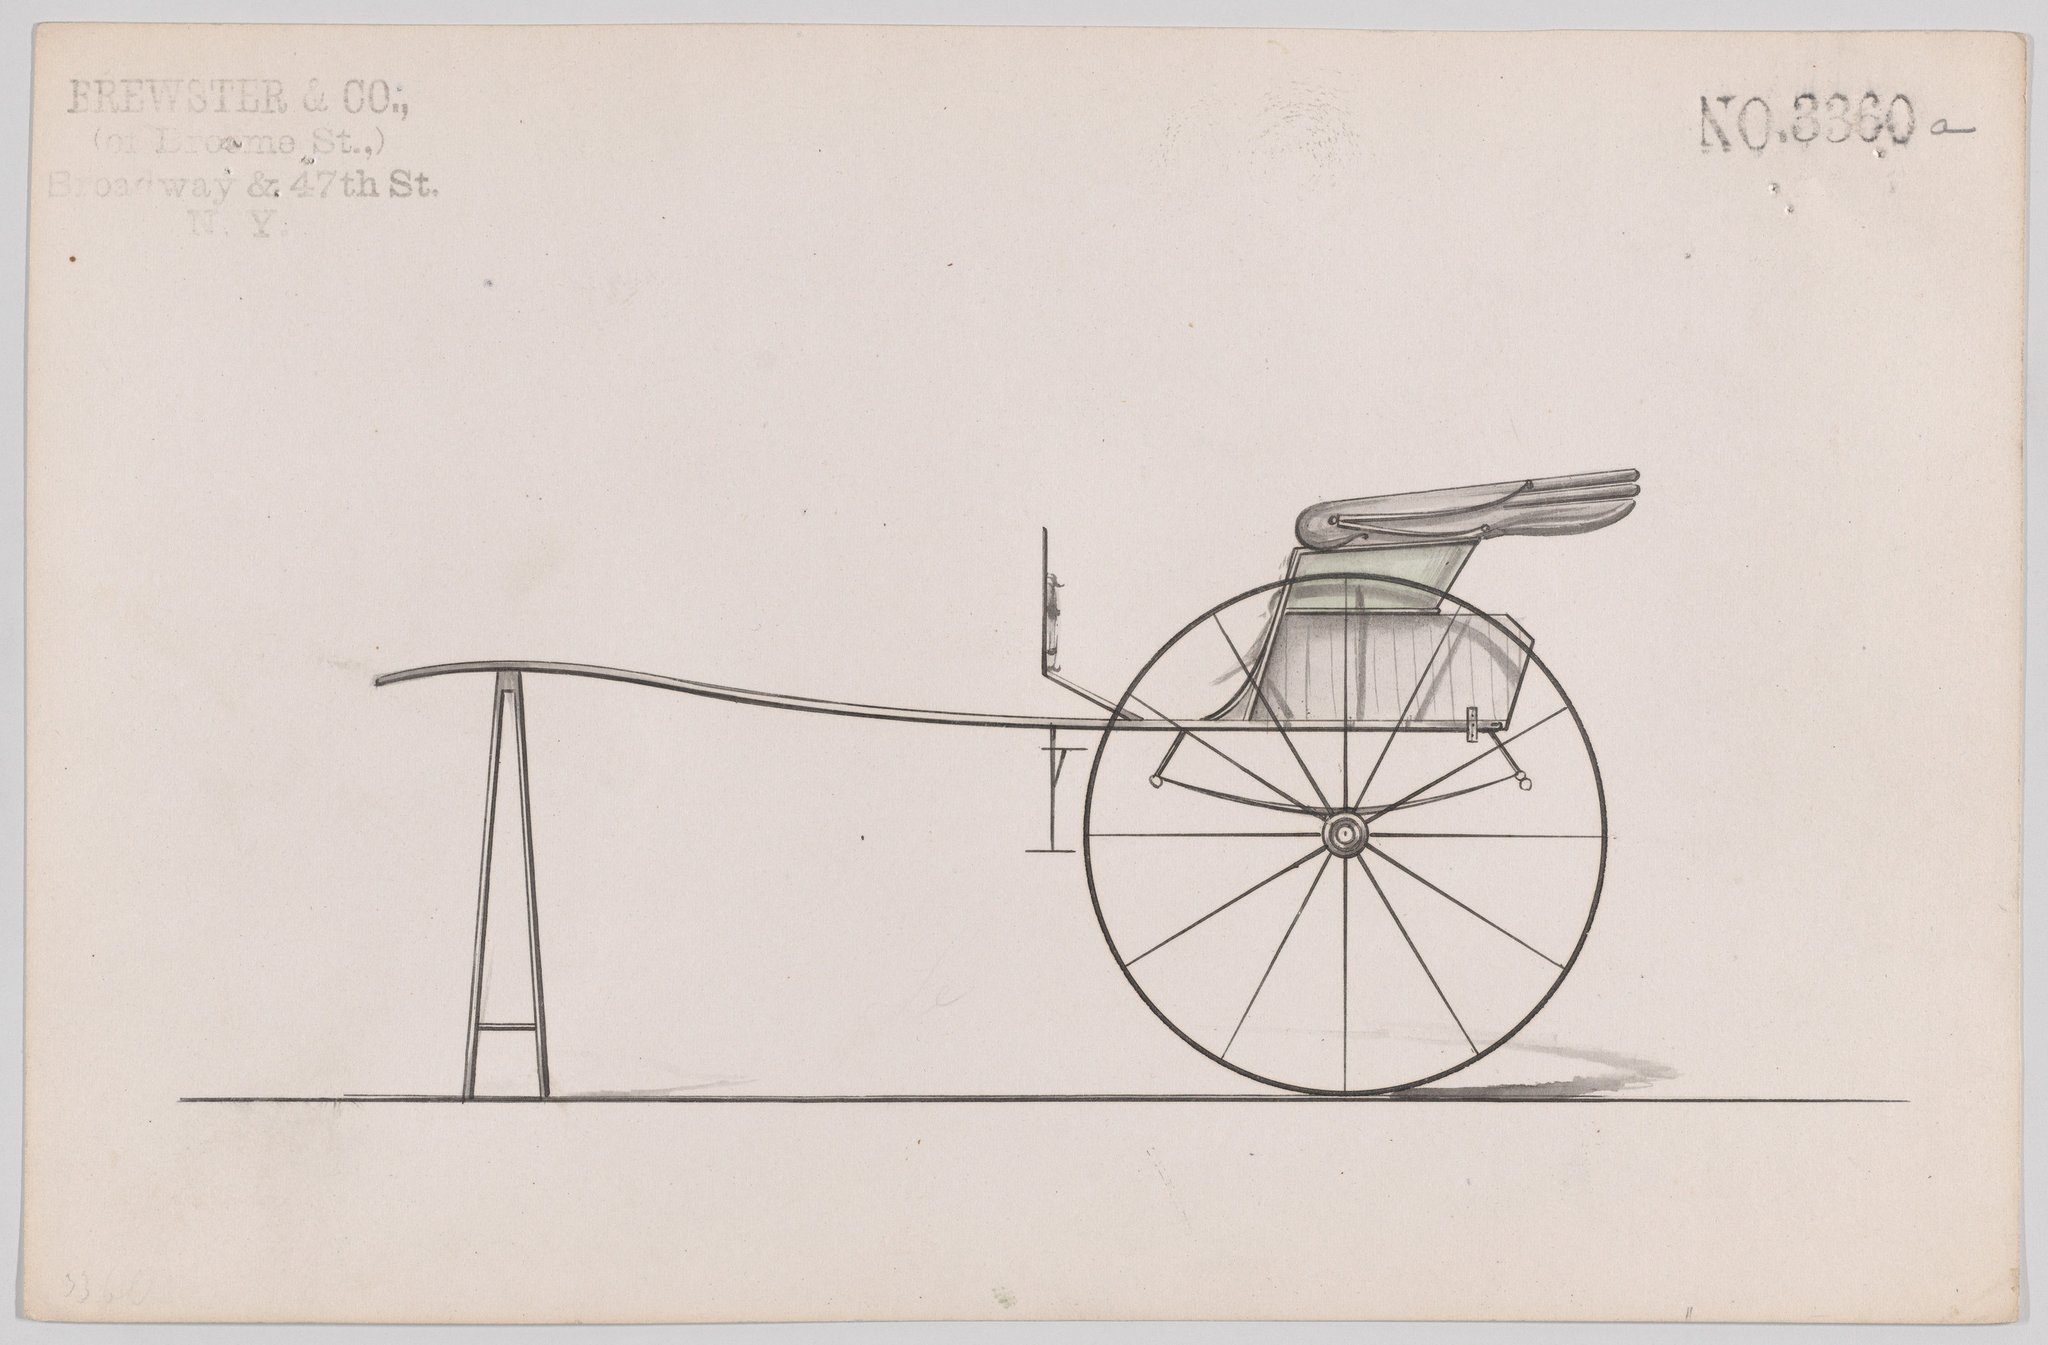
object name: drawing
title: Gig #3360a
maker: brewster & co.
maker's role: manufacturer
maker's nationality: american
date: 1877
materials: gouache, ink, watercolor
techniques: pen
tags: carriages